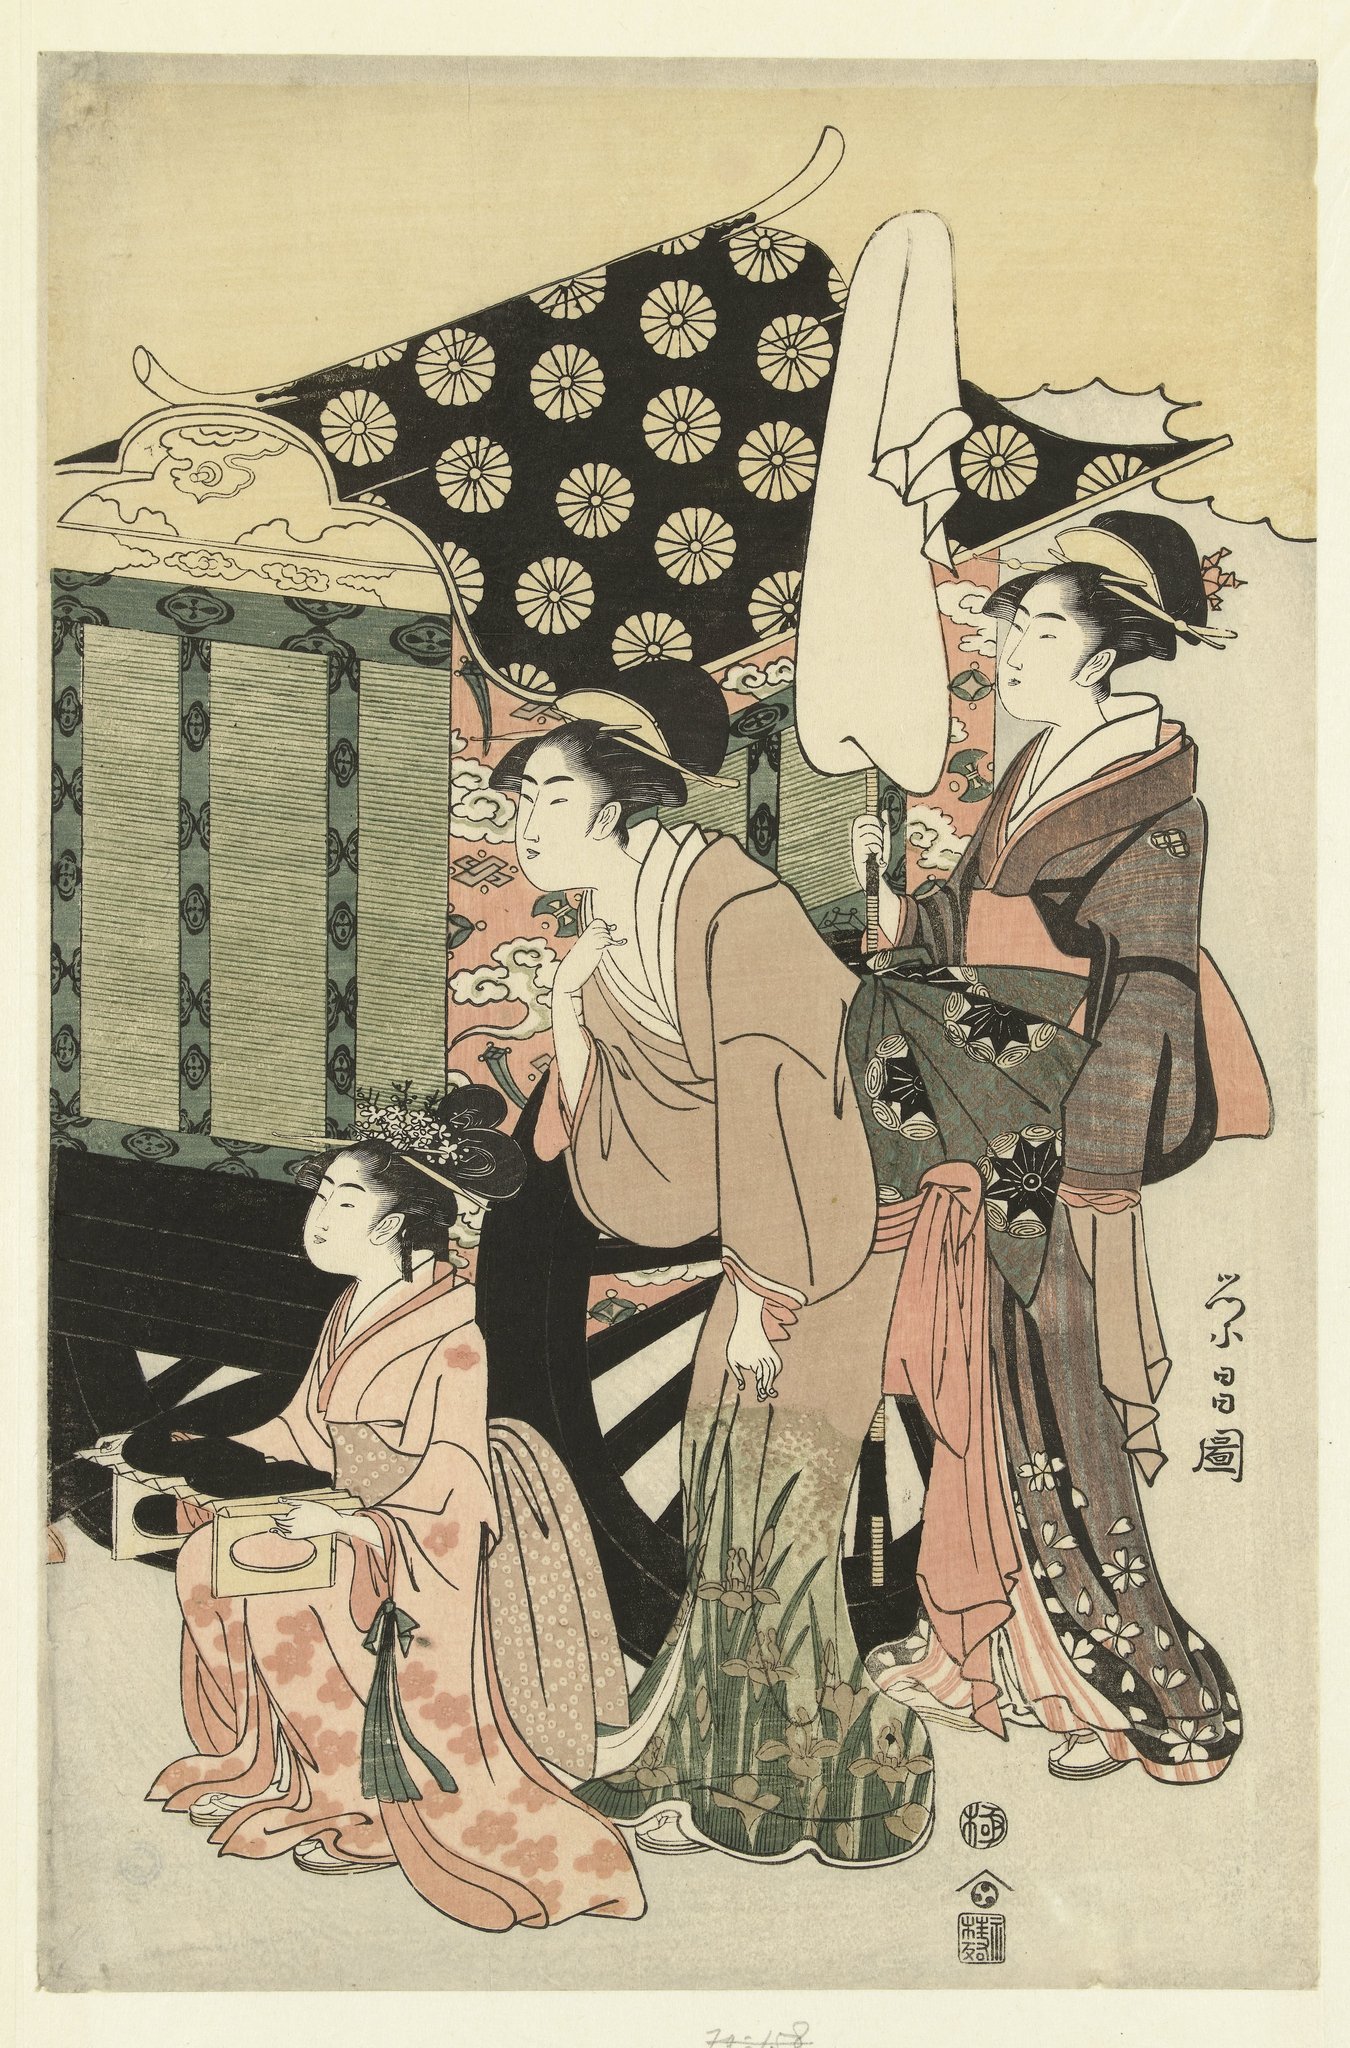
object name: print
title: Prins Genji en Yugao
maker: chokosai eishô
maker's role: print maker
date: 1795-1800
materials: paper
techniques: woodcut, nishiki e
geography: tokyo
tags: girl (child between toddler and youth), adult woman (+ two persons), passenger carriage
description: Twee vrouwen, één een wit vaandel dragend, en een meisje met dienblad in handen, naast rijtuig; onder geel wolkpatroon.